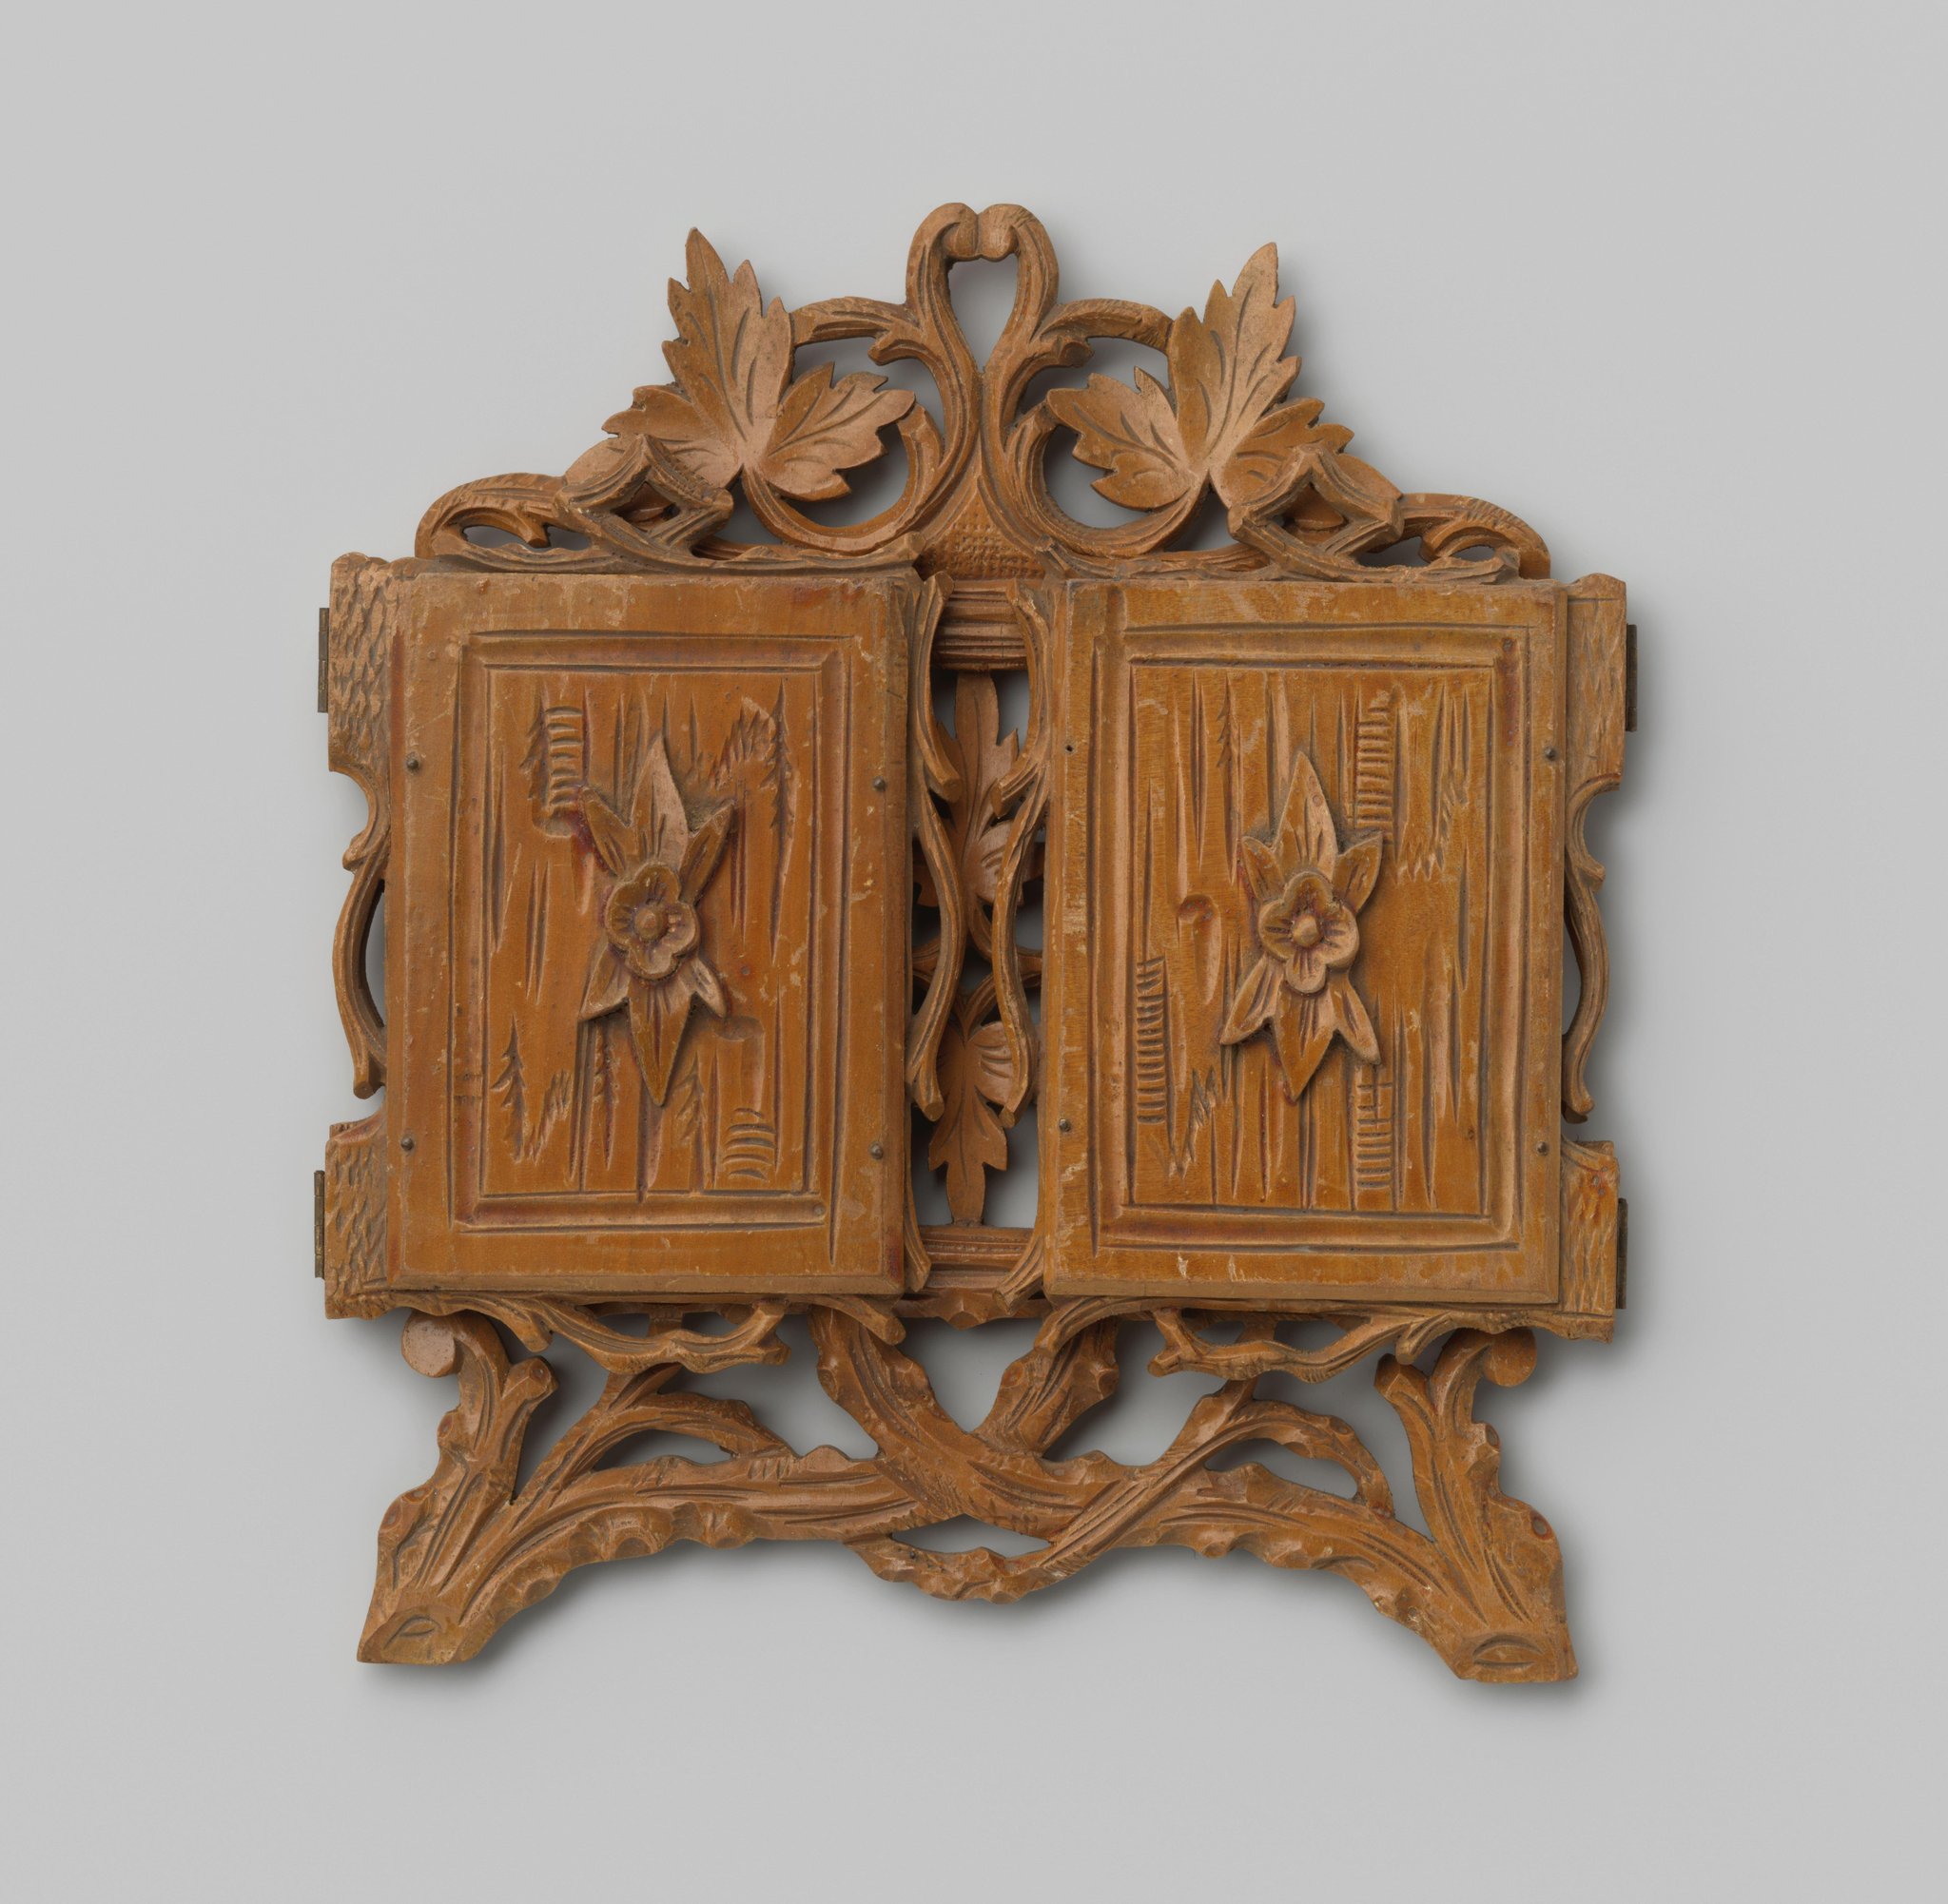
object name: frame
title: Lege lijst met vierluik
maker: Anonymous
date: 1880-1900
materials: glass, metal, wood